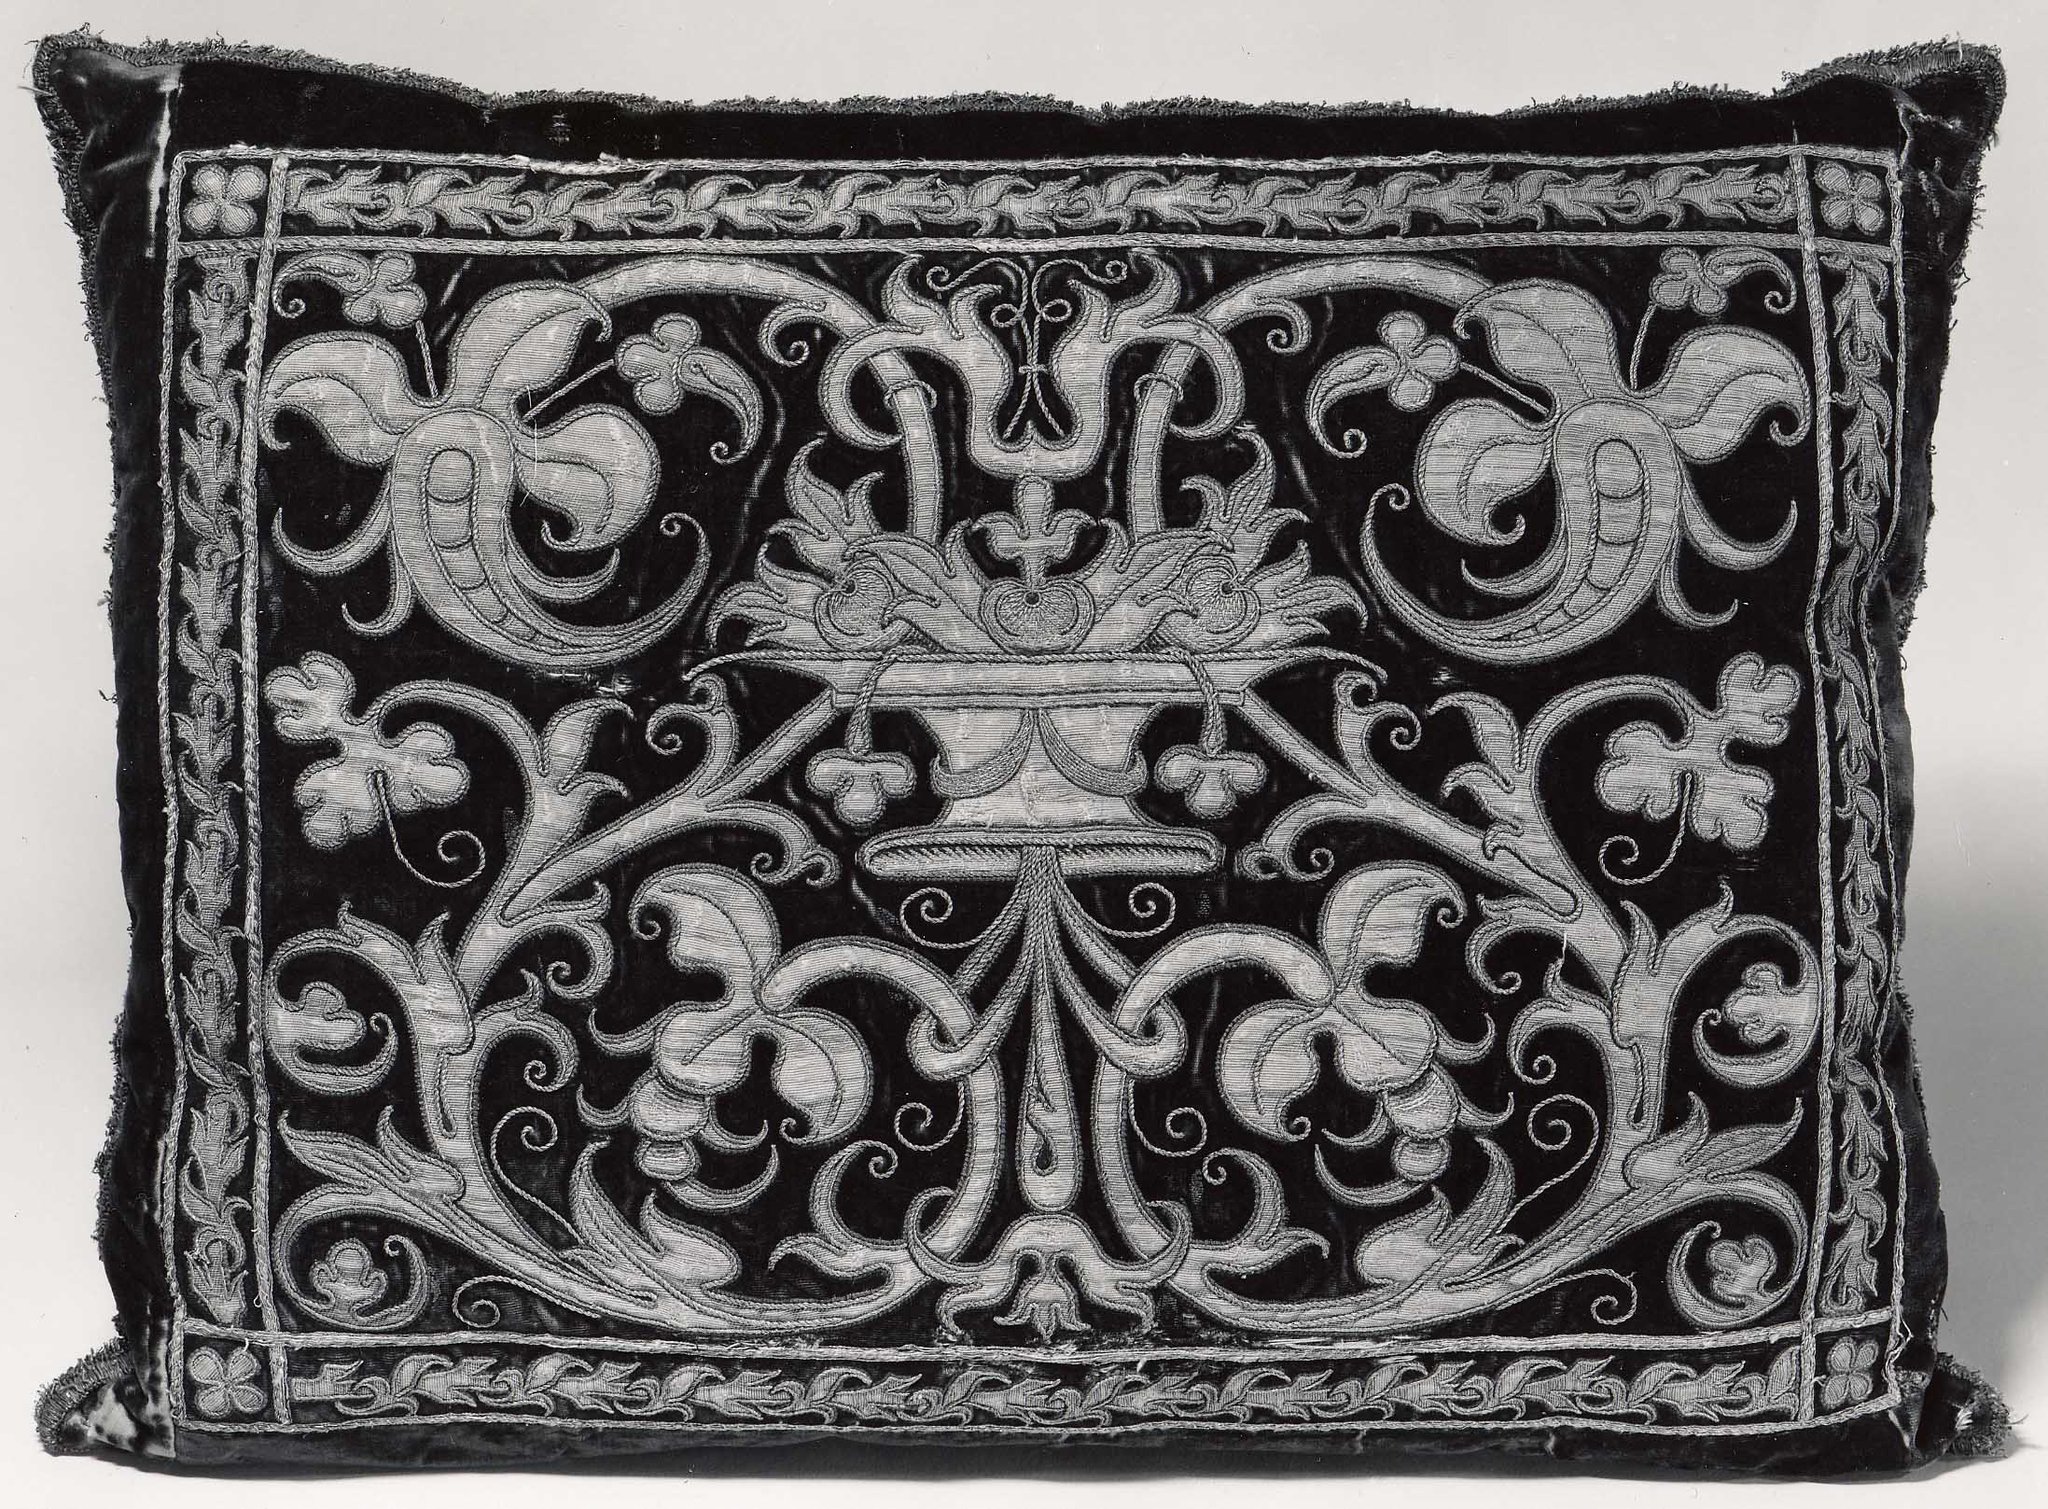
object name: clothing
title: Apparel made into cushion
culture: spanish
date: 1601-1700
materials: metal, silk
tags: flowers